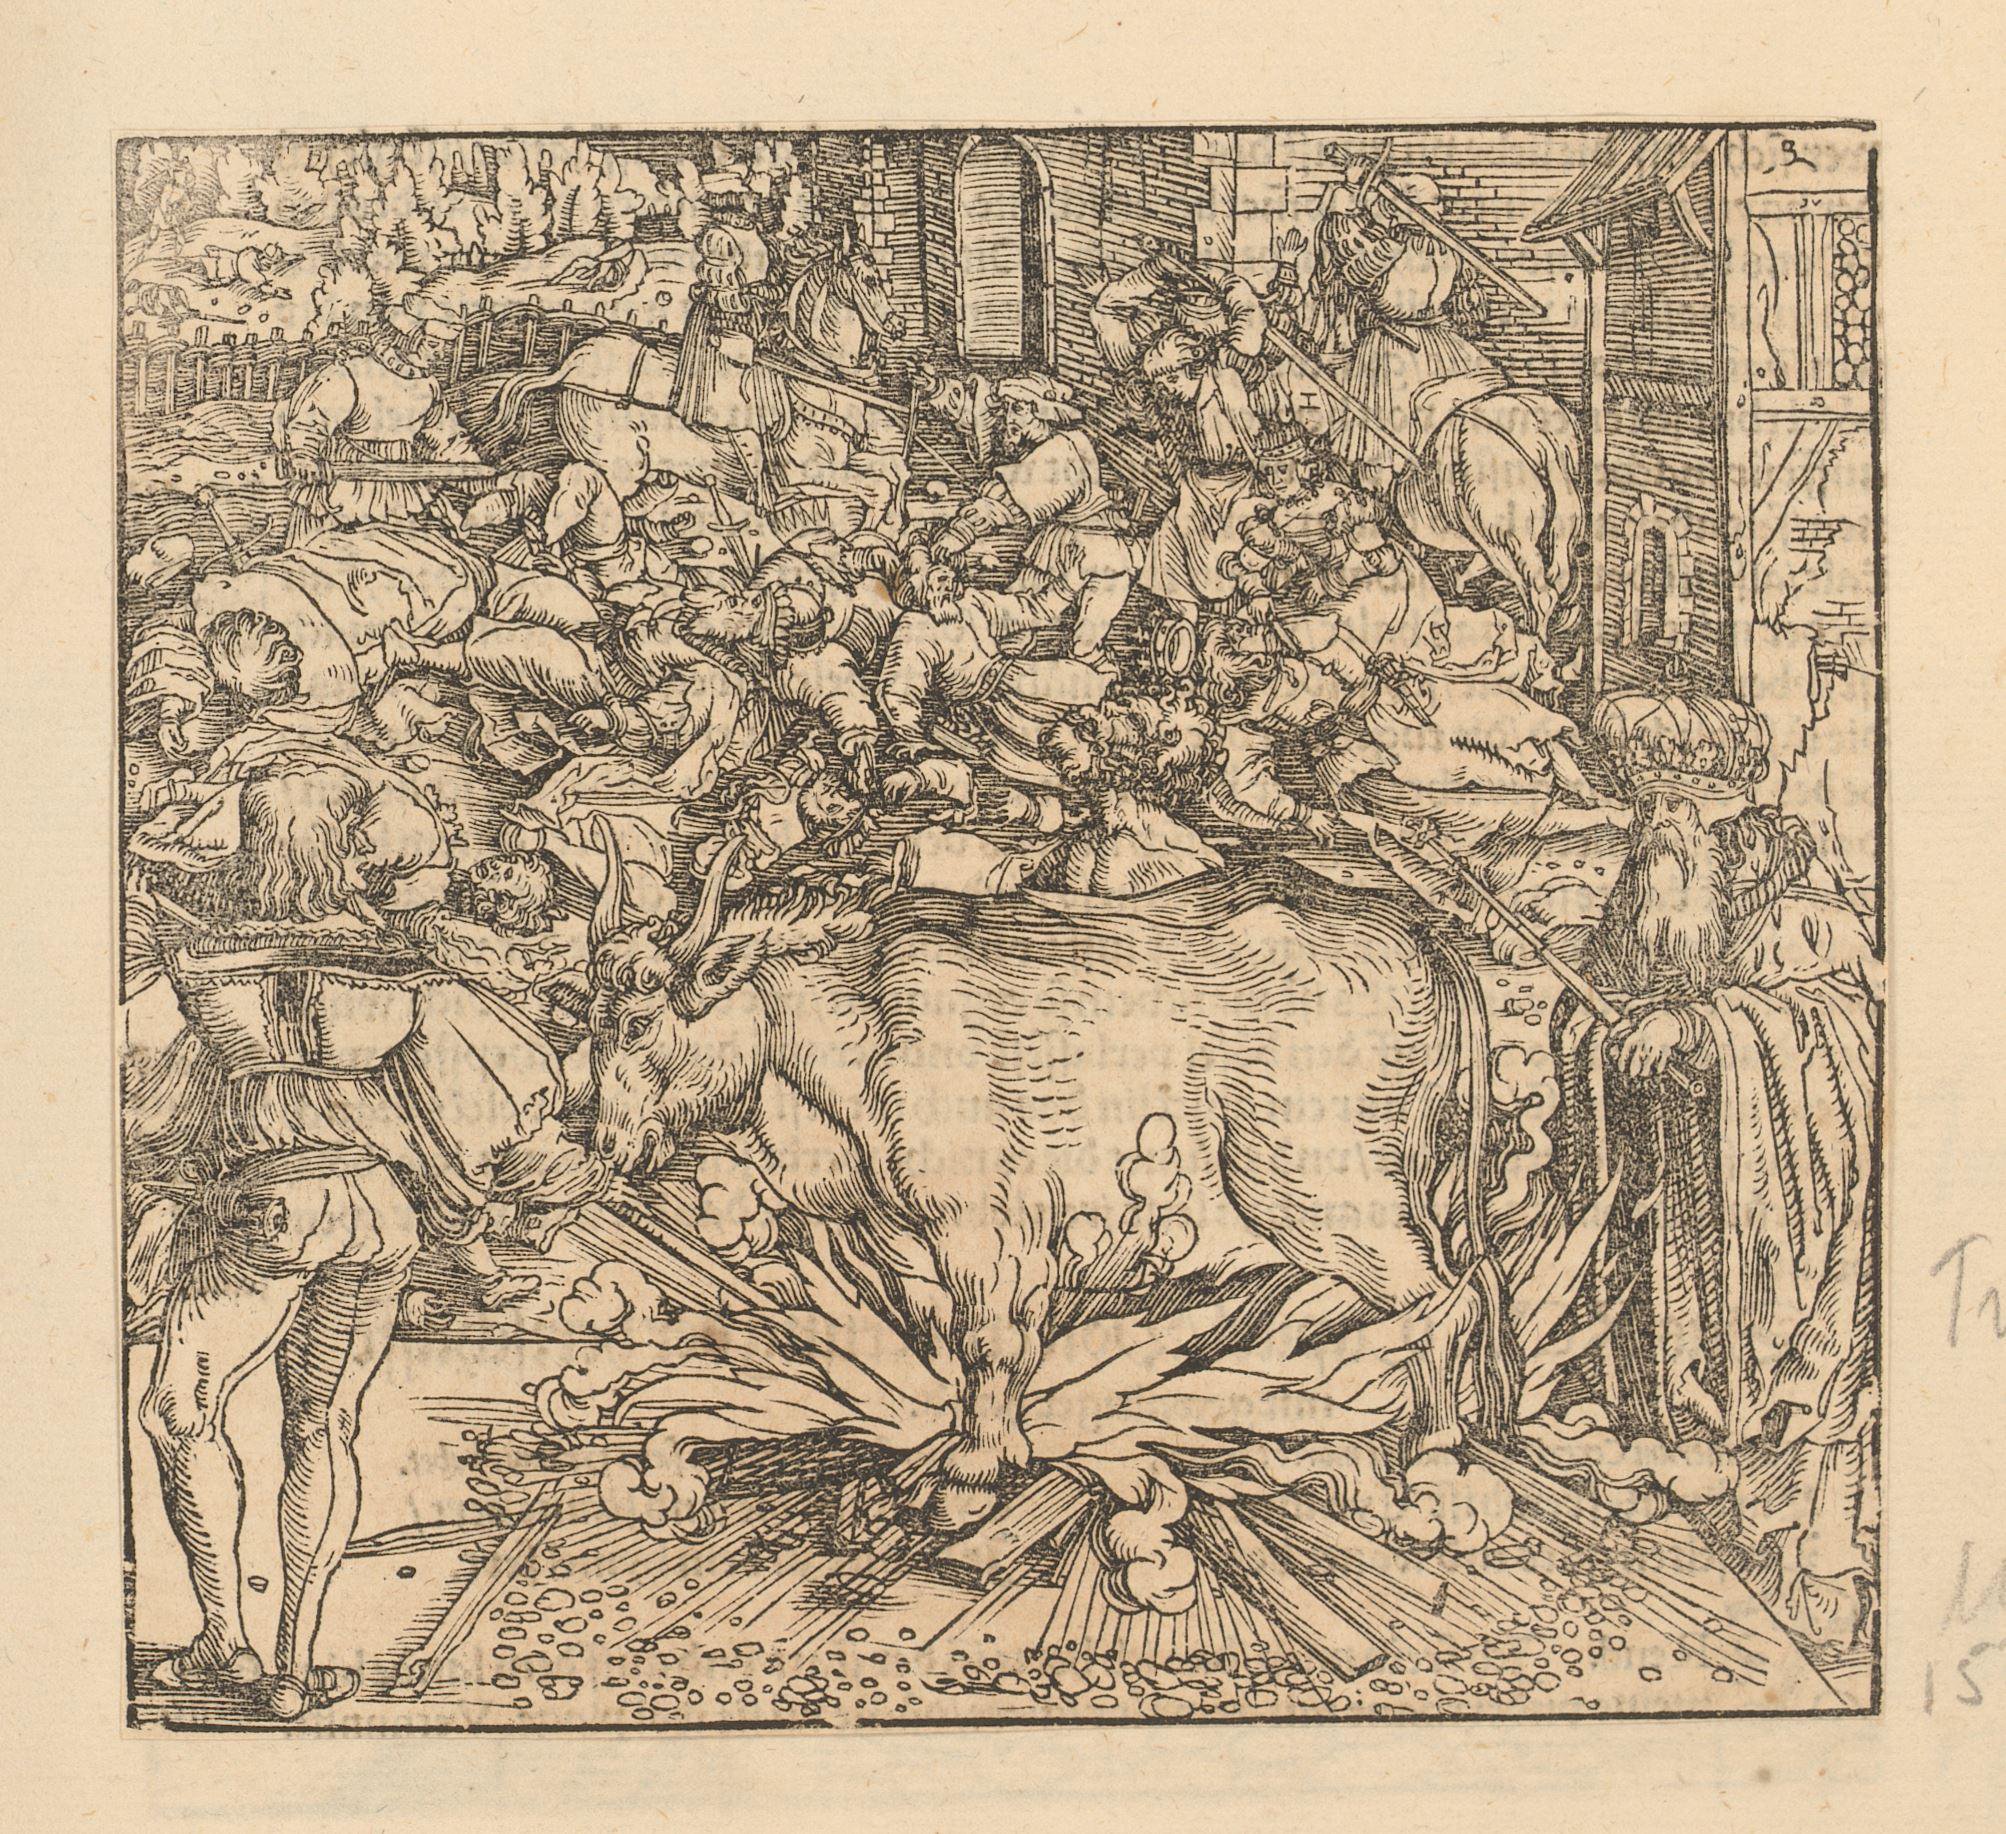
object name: book illustration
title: Mensen worden afgeslacht en een stier wordt geofferd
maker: Anonymous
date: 1514-1532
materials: paper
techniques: letterpress printing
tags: murder, sacrifice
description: Deze prent is gebruikt in: Petrarca, Francesco. Von der Artzney bayder Glück, des guten und widerwertigen: unnd weß sich ain yeder inn Gelück und Unglück halten sol (...). Augsburg: Heinrich Steiner, 1532. Deze uitgave is ook bekend onder de titel 'Trostspiegel in Glück und Unglück'.